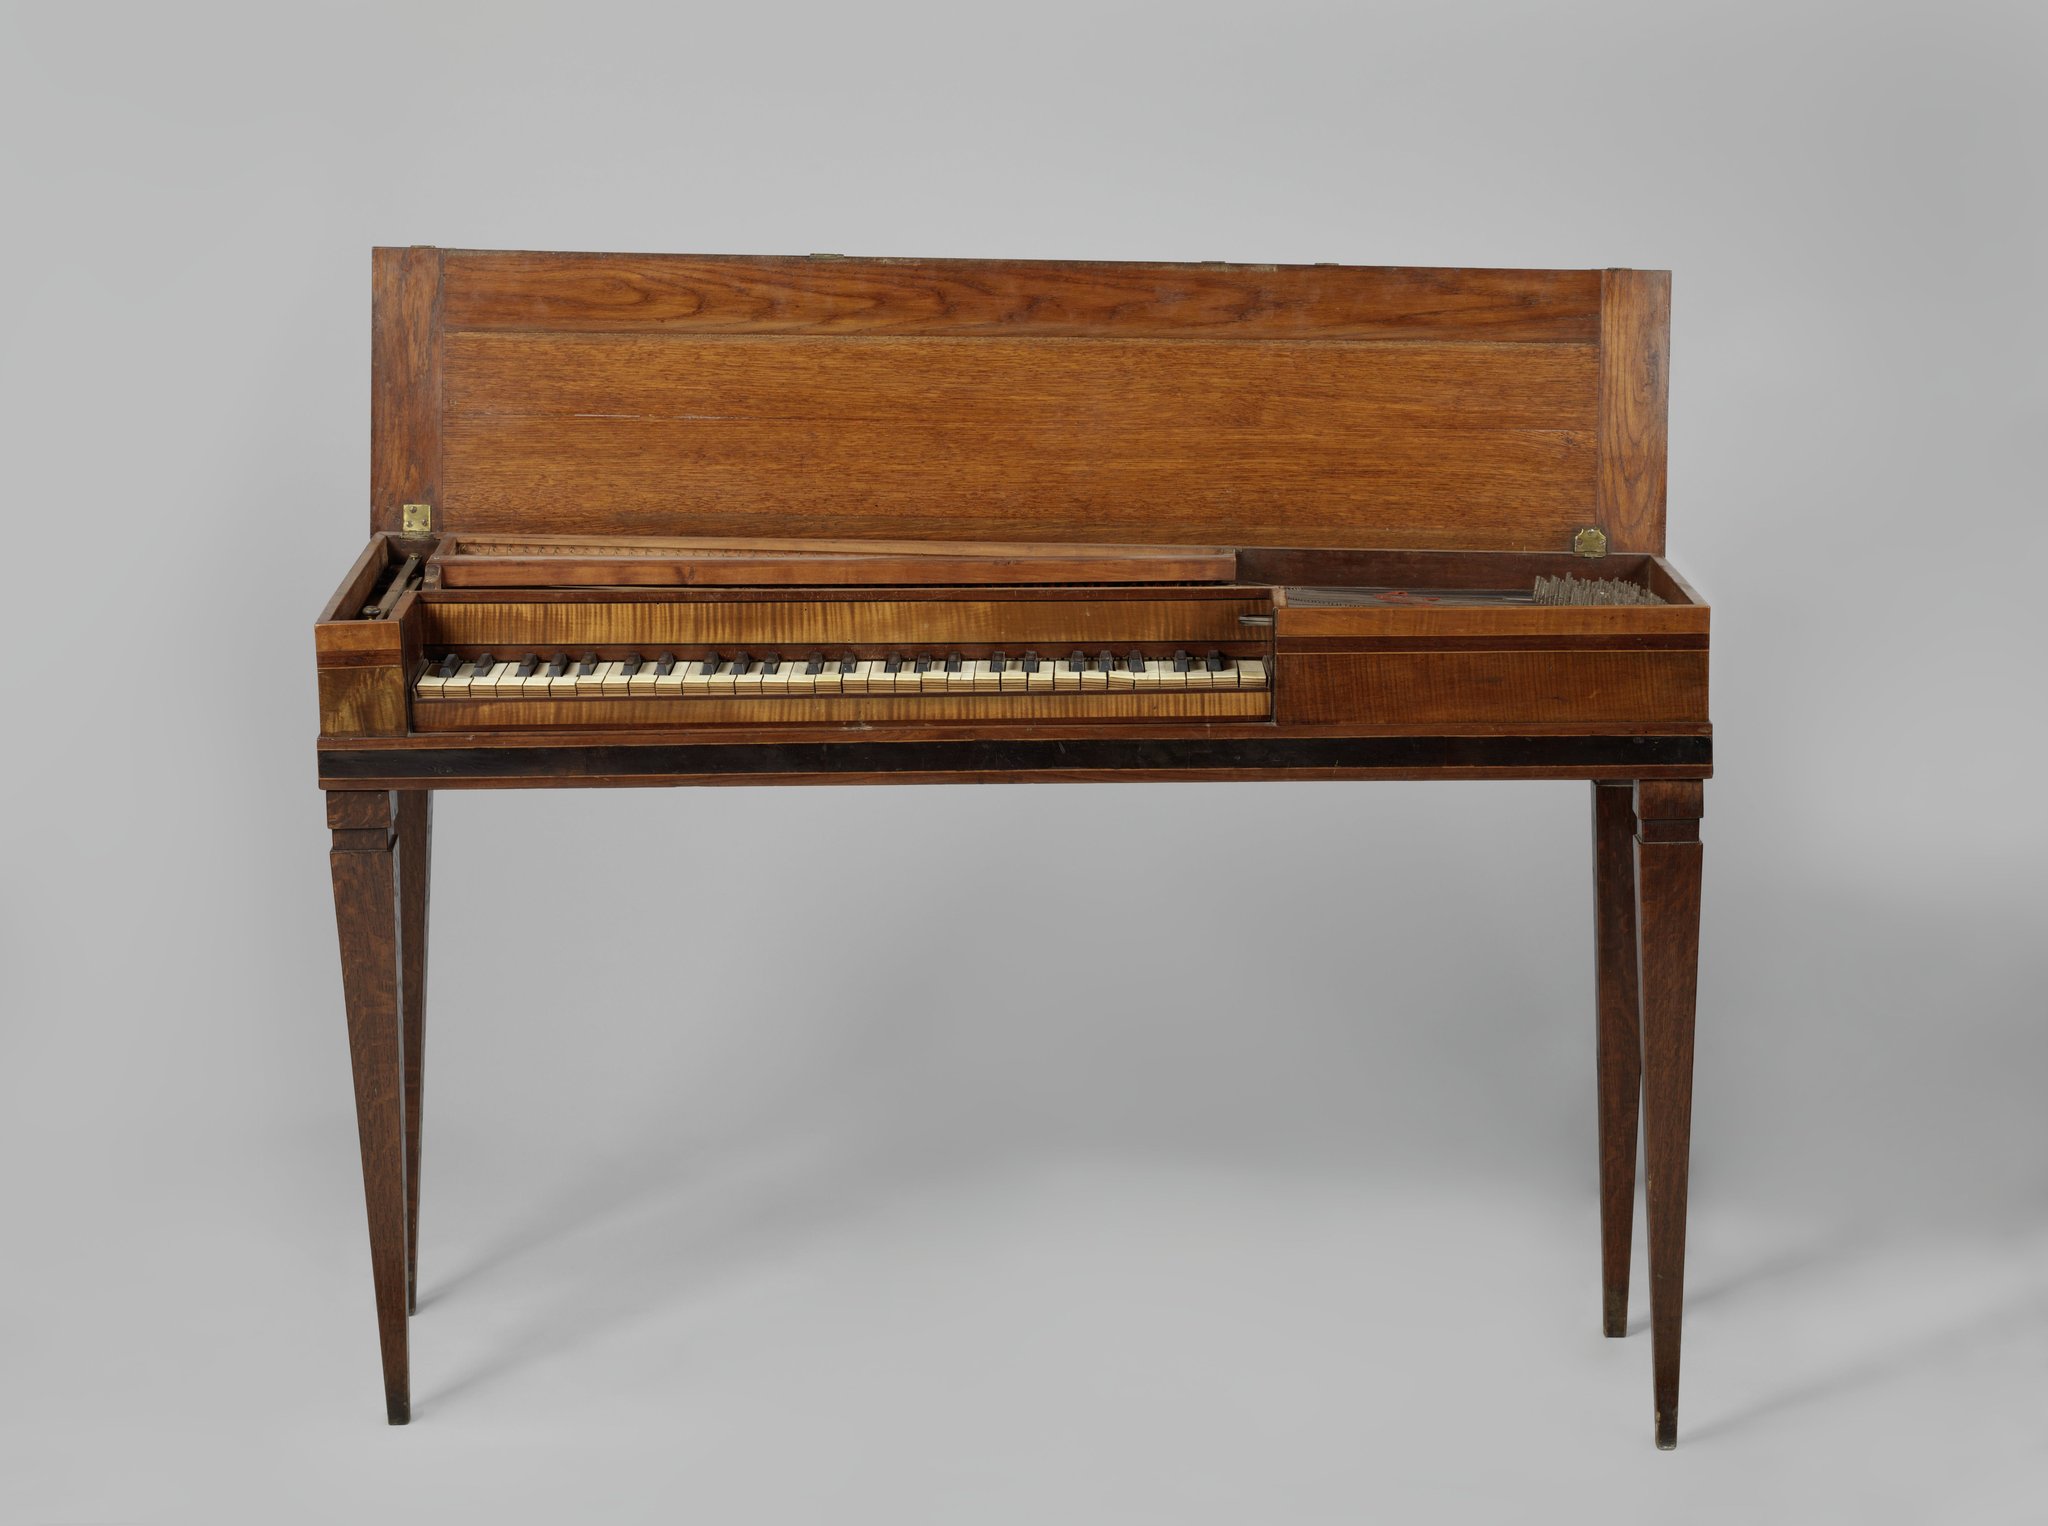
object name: square piano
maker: Anonymous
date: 1775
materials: brass, wood, iron, ivory, leather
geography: netherlands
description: The square pianos that first came into fashion in London in the 1760s were inspired by German examples. The rage for the ‘new’ instrument soon spread to France and a little later, to the Netherlands, Italy, Germany, and Spain. The outer appearance of this example suggests Dutch origins, even if the hammer action is in the English style.